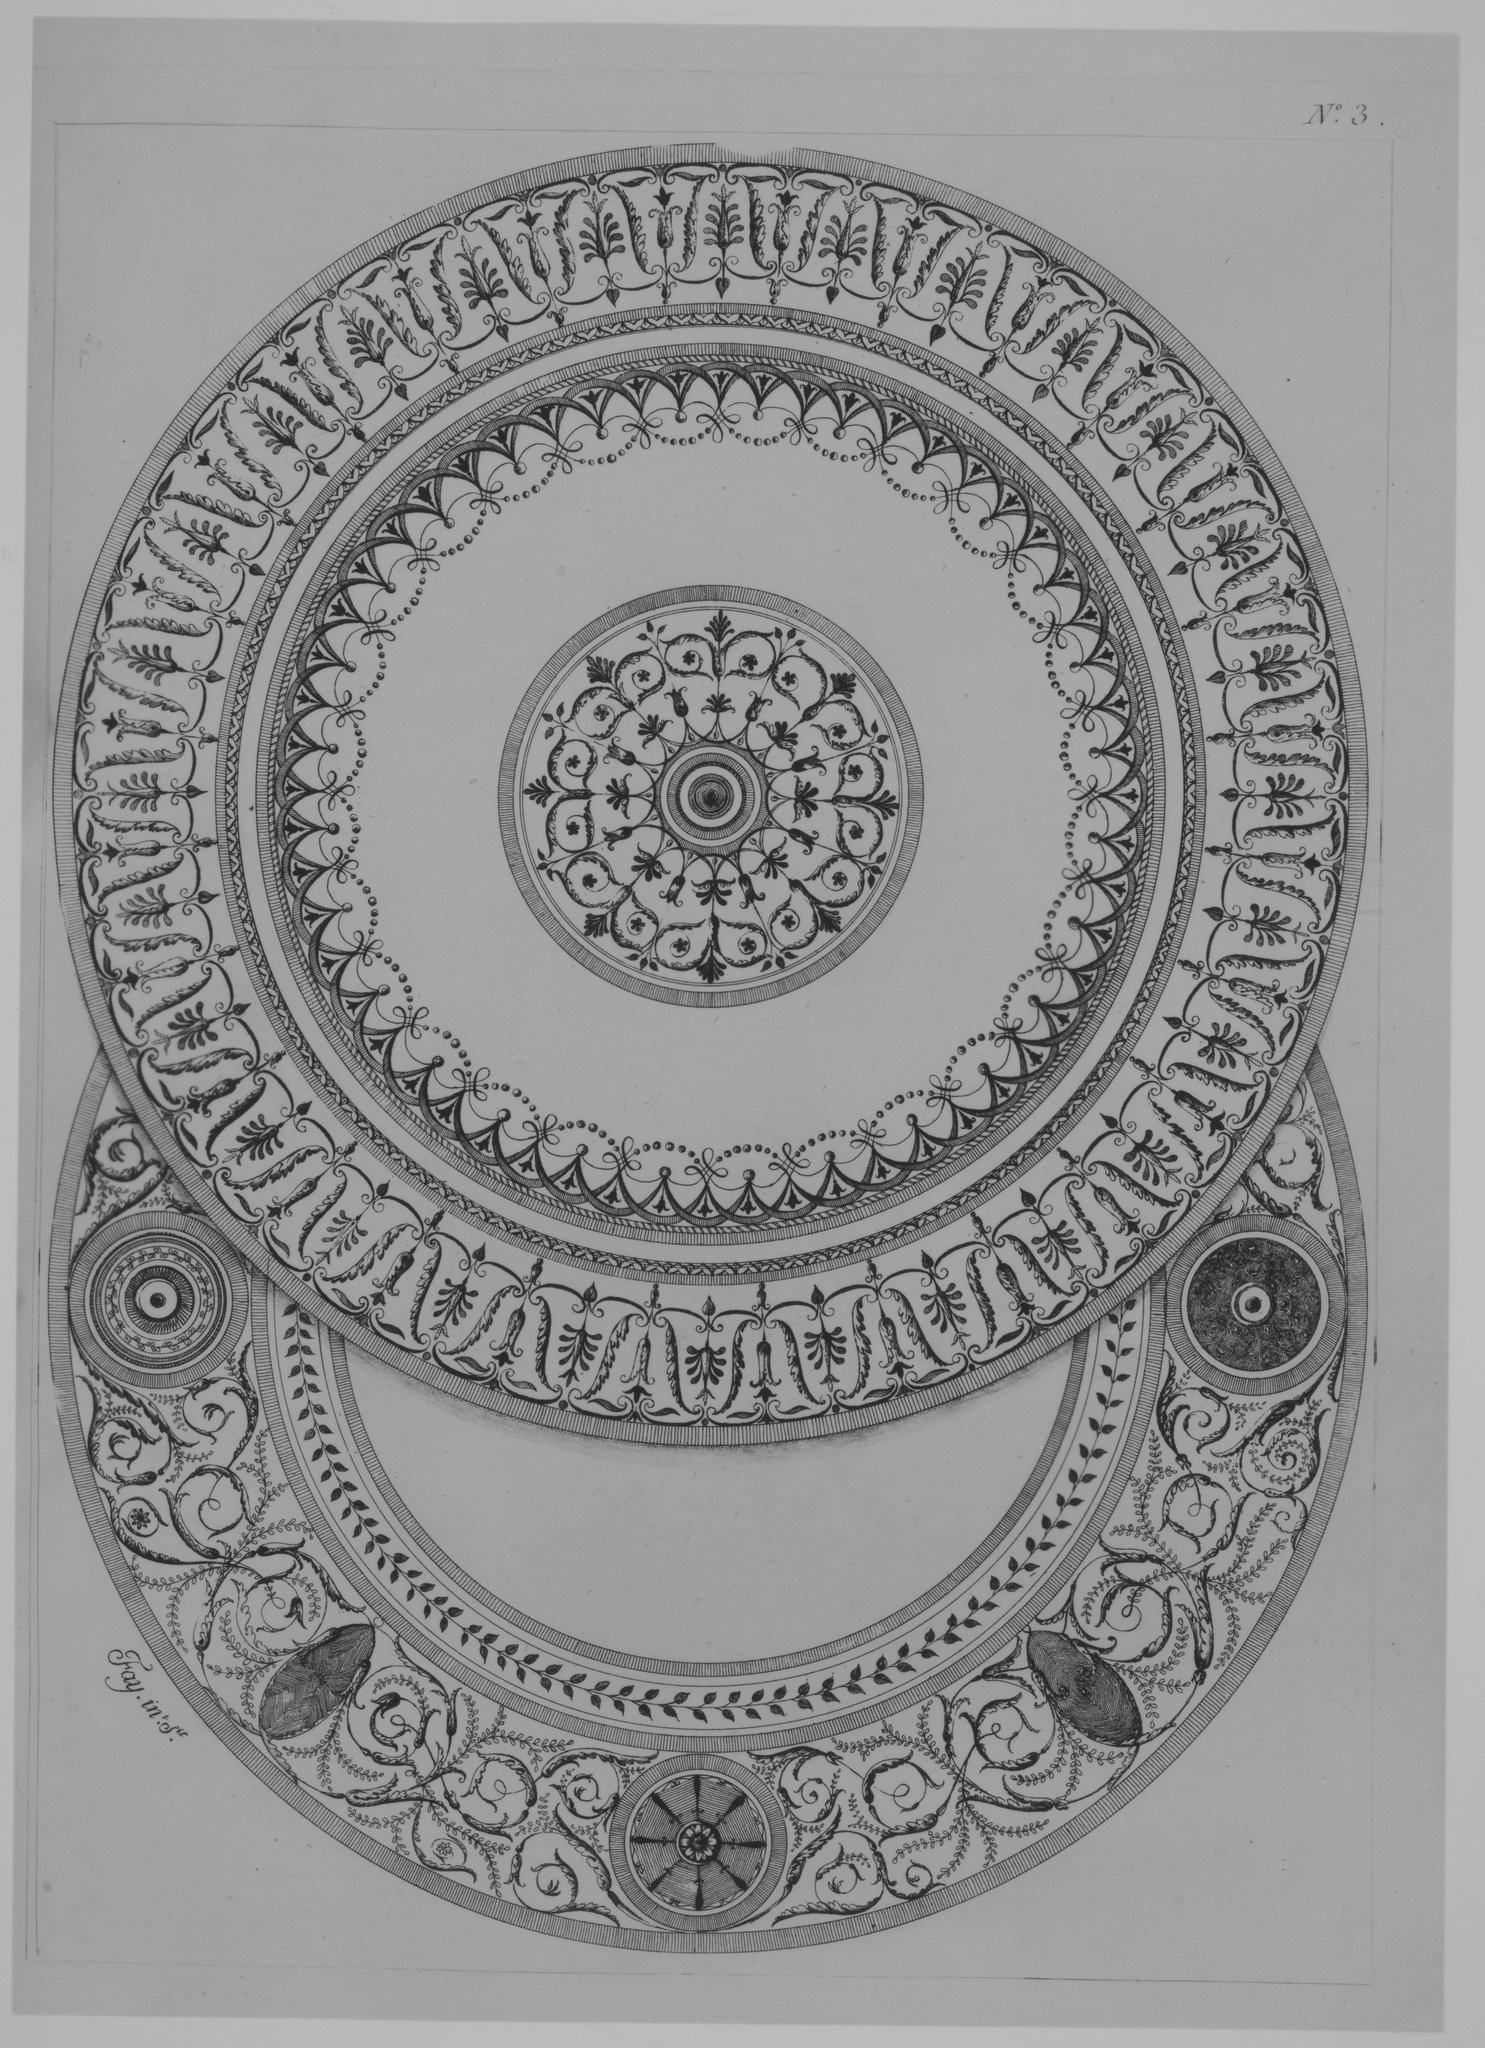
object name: book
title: Oeuvres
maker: j. b. fay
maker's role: artist and engraver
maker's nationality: french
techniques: engraving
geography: france